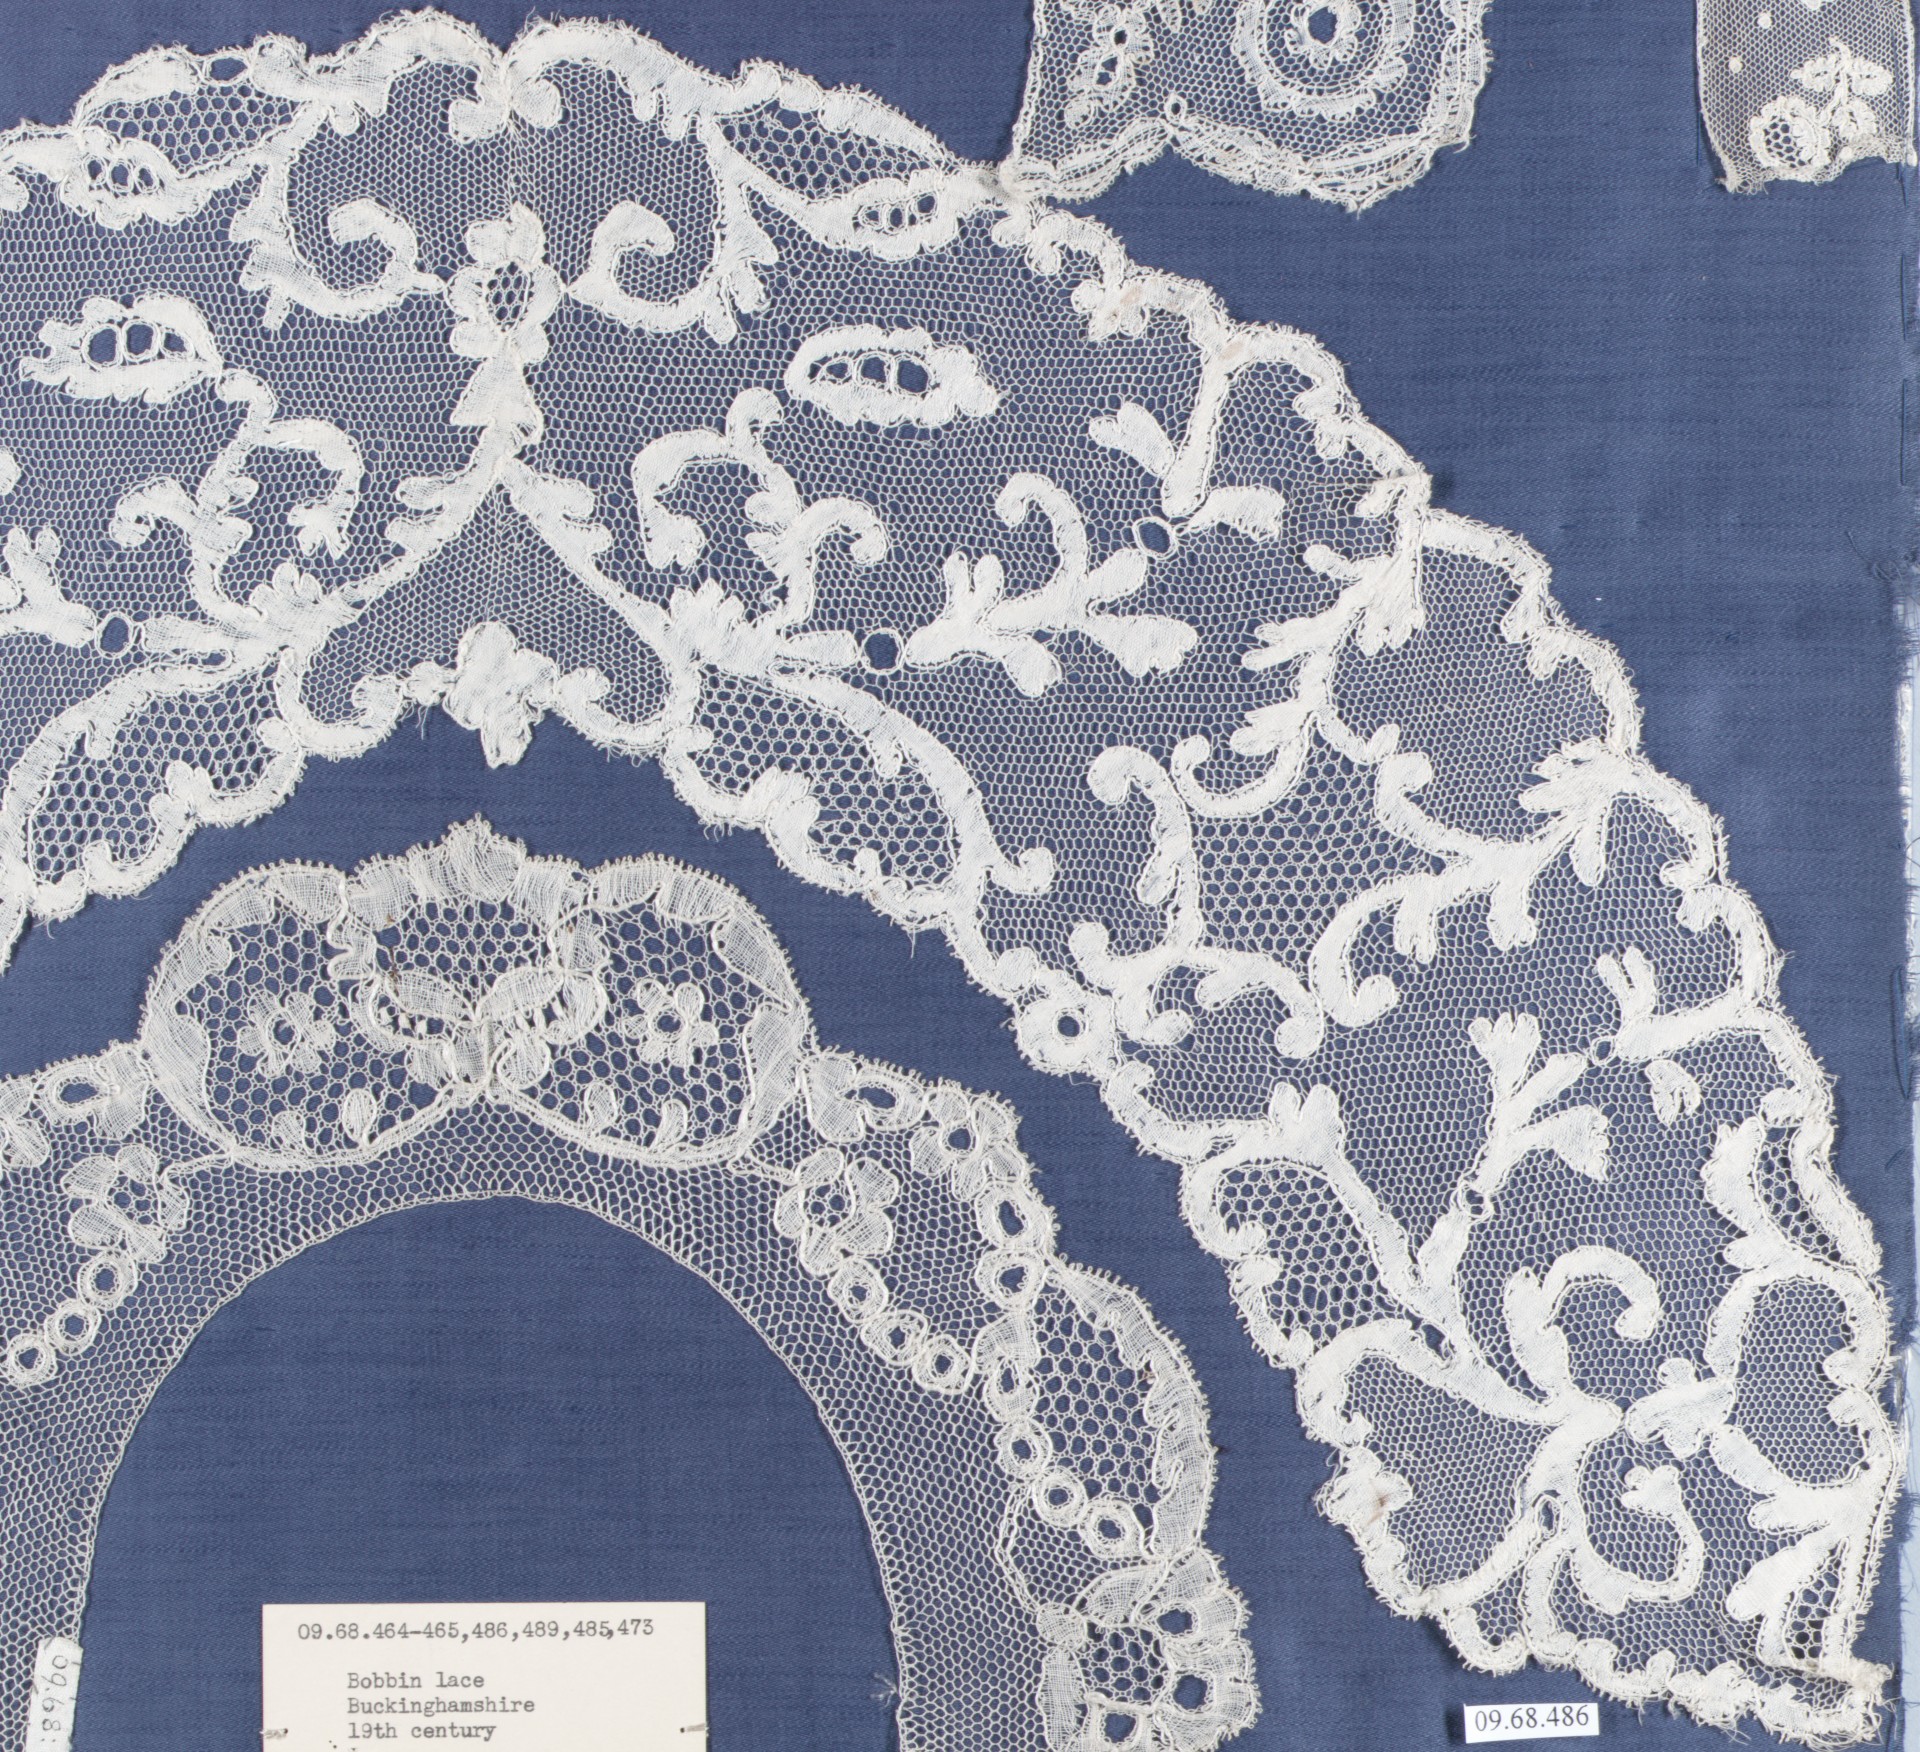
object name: fichu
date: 1801-1900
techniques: lace